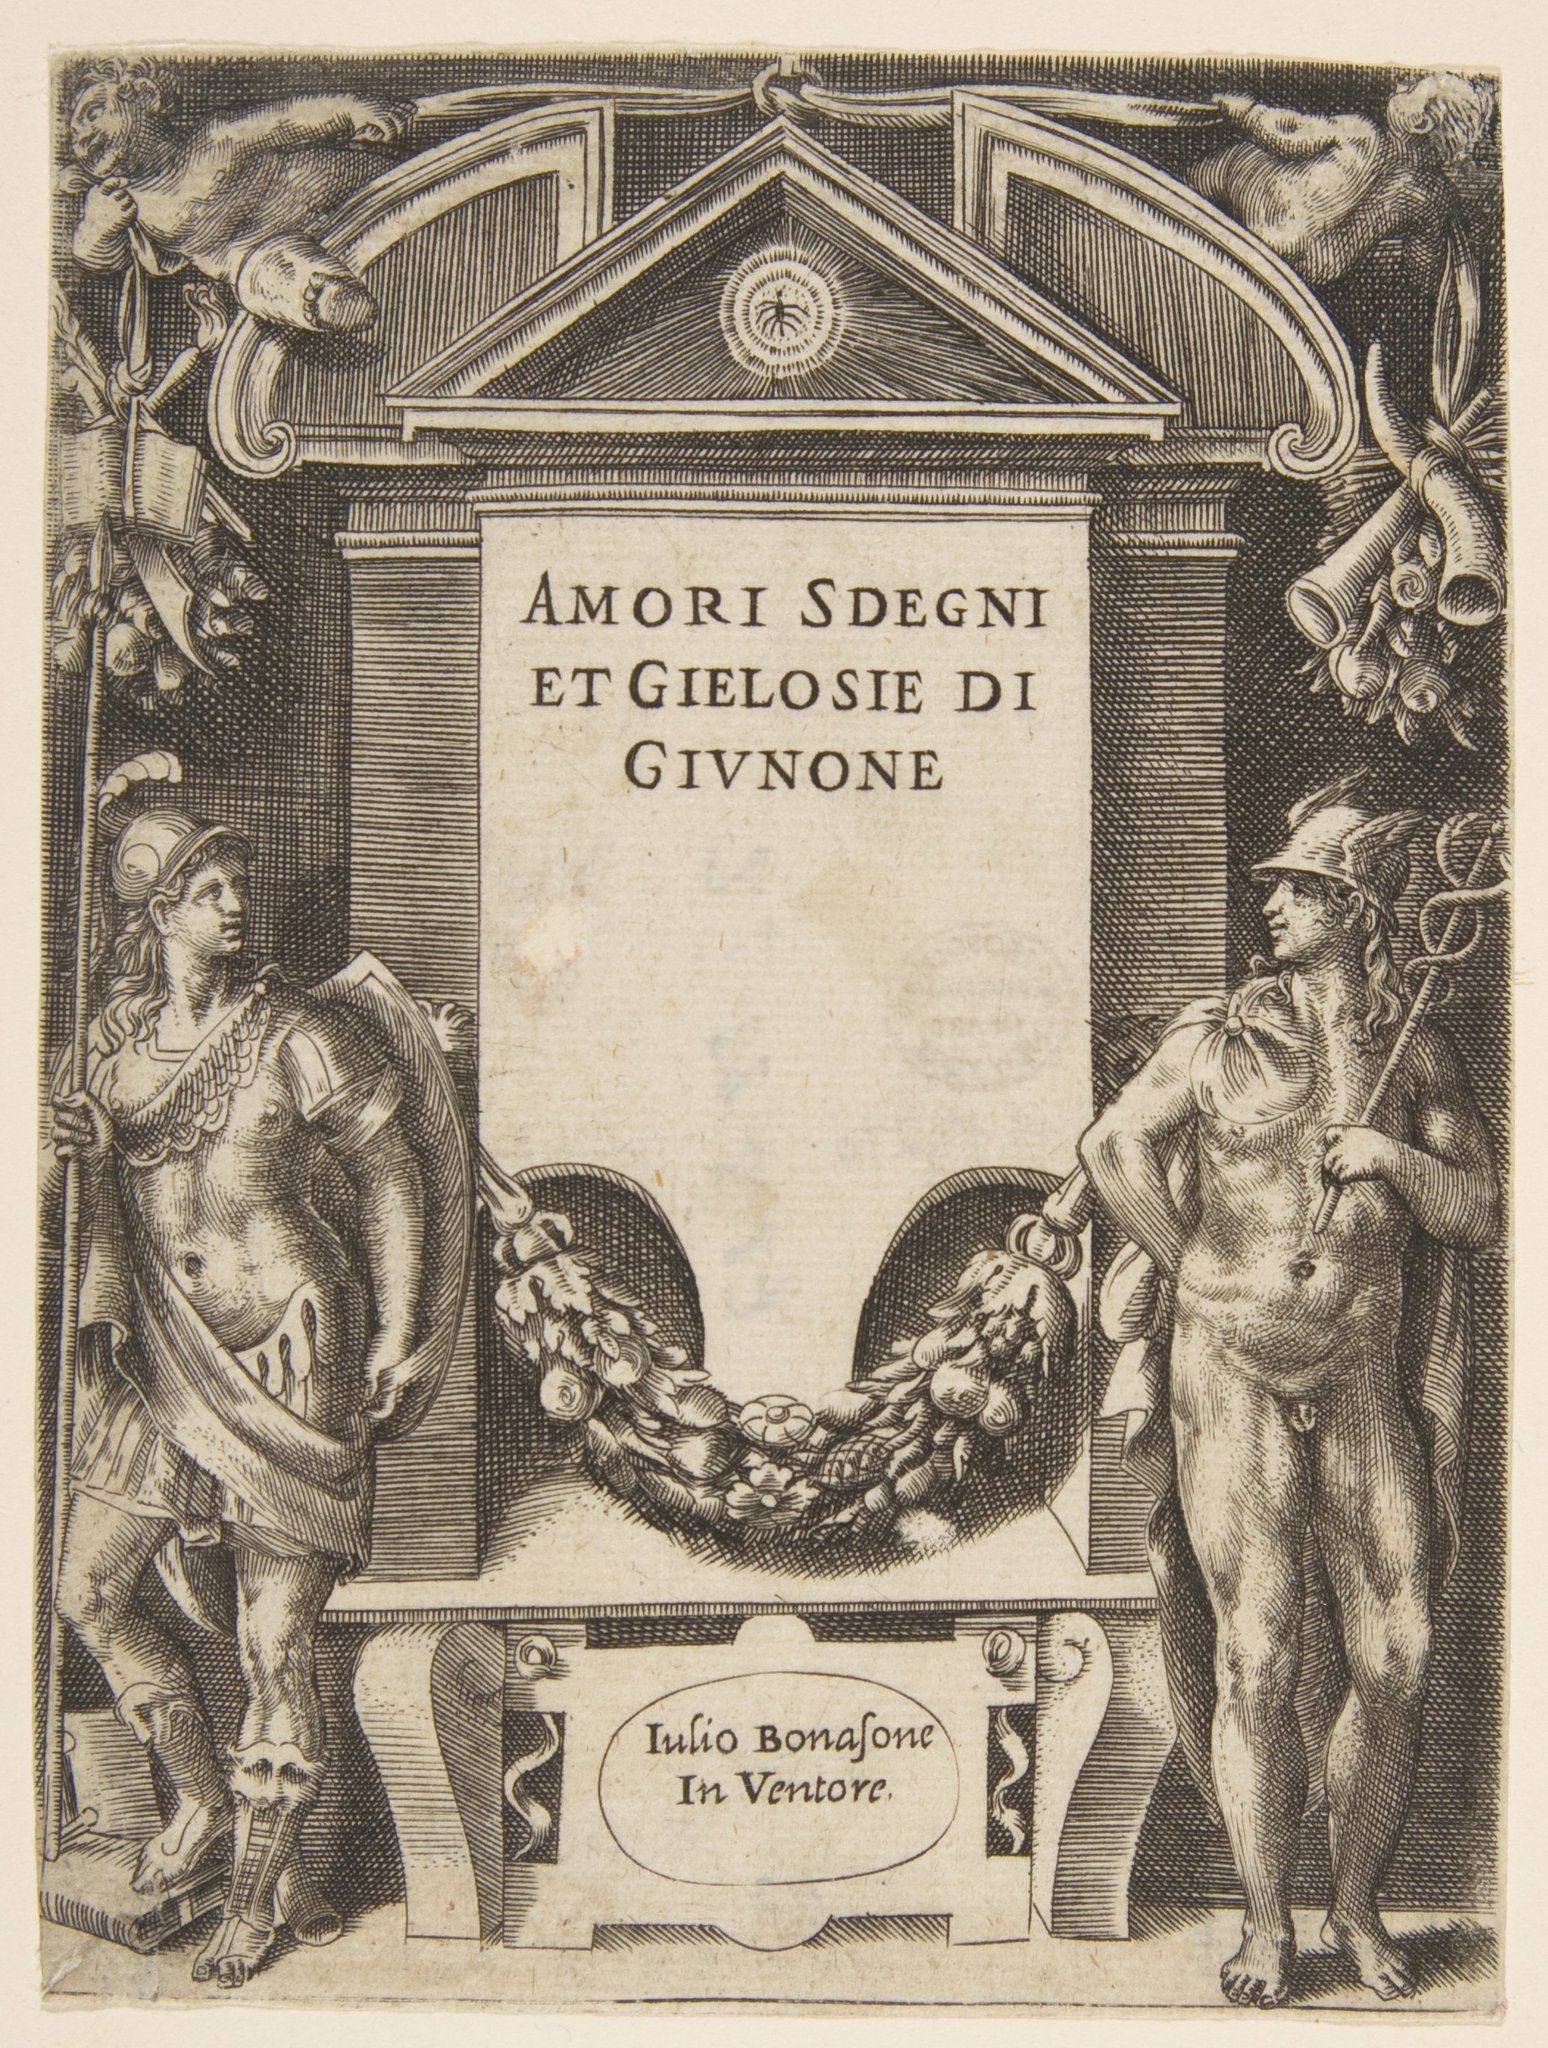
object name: print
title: Title plate to "Loves, Rages and Jealousies of Juno"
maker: giulio bonasone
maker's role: artist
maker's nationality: italian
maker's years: 1510-1576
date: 1531-1576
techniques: engraving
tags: garlands,men,male nudes